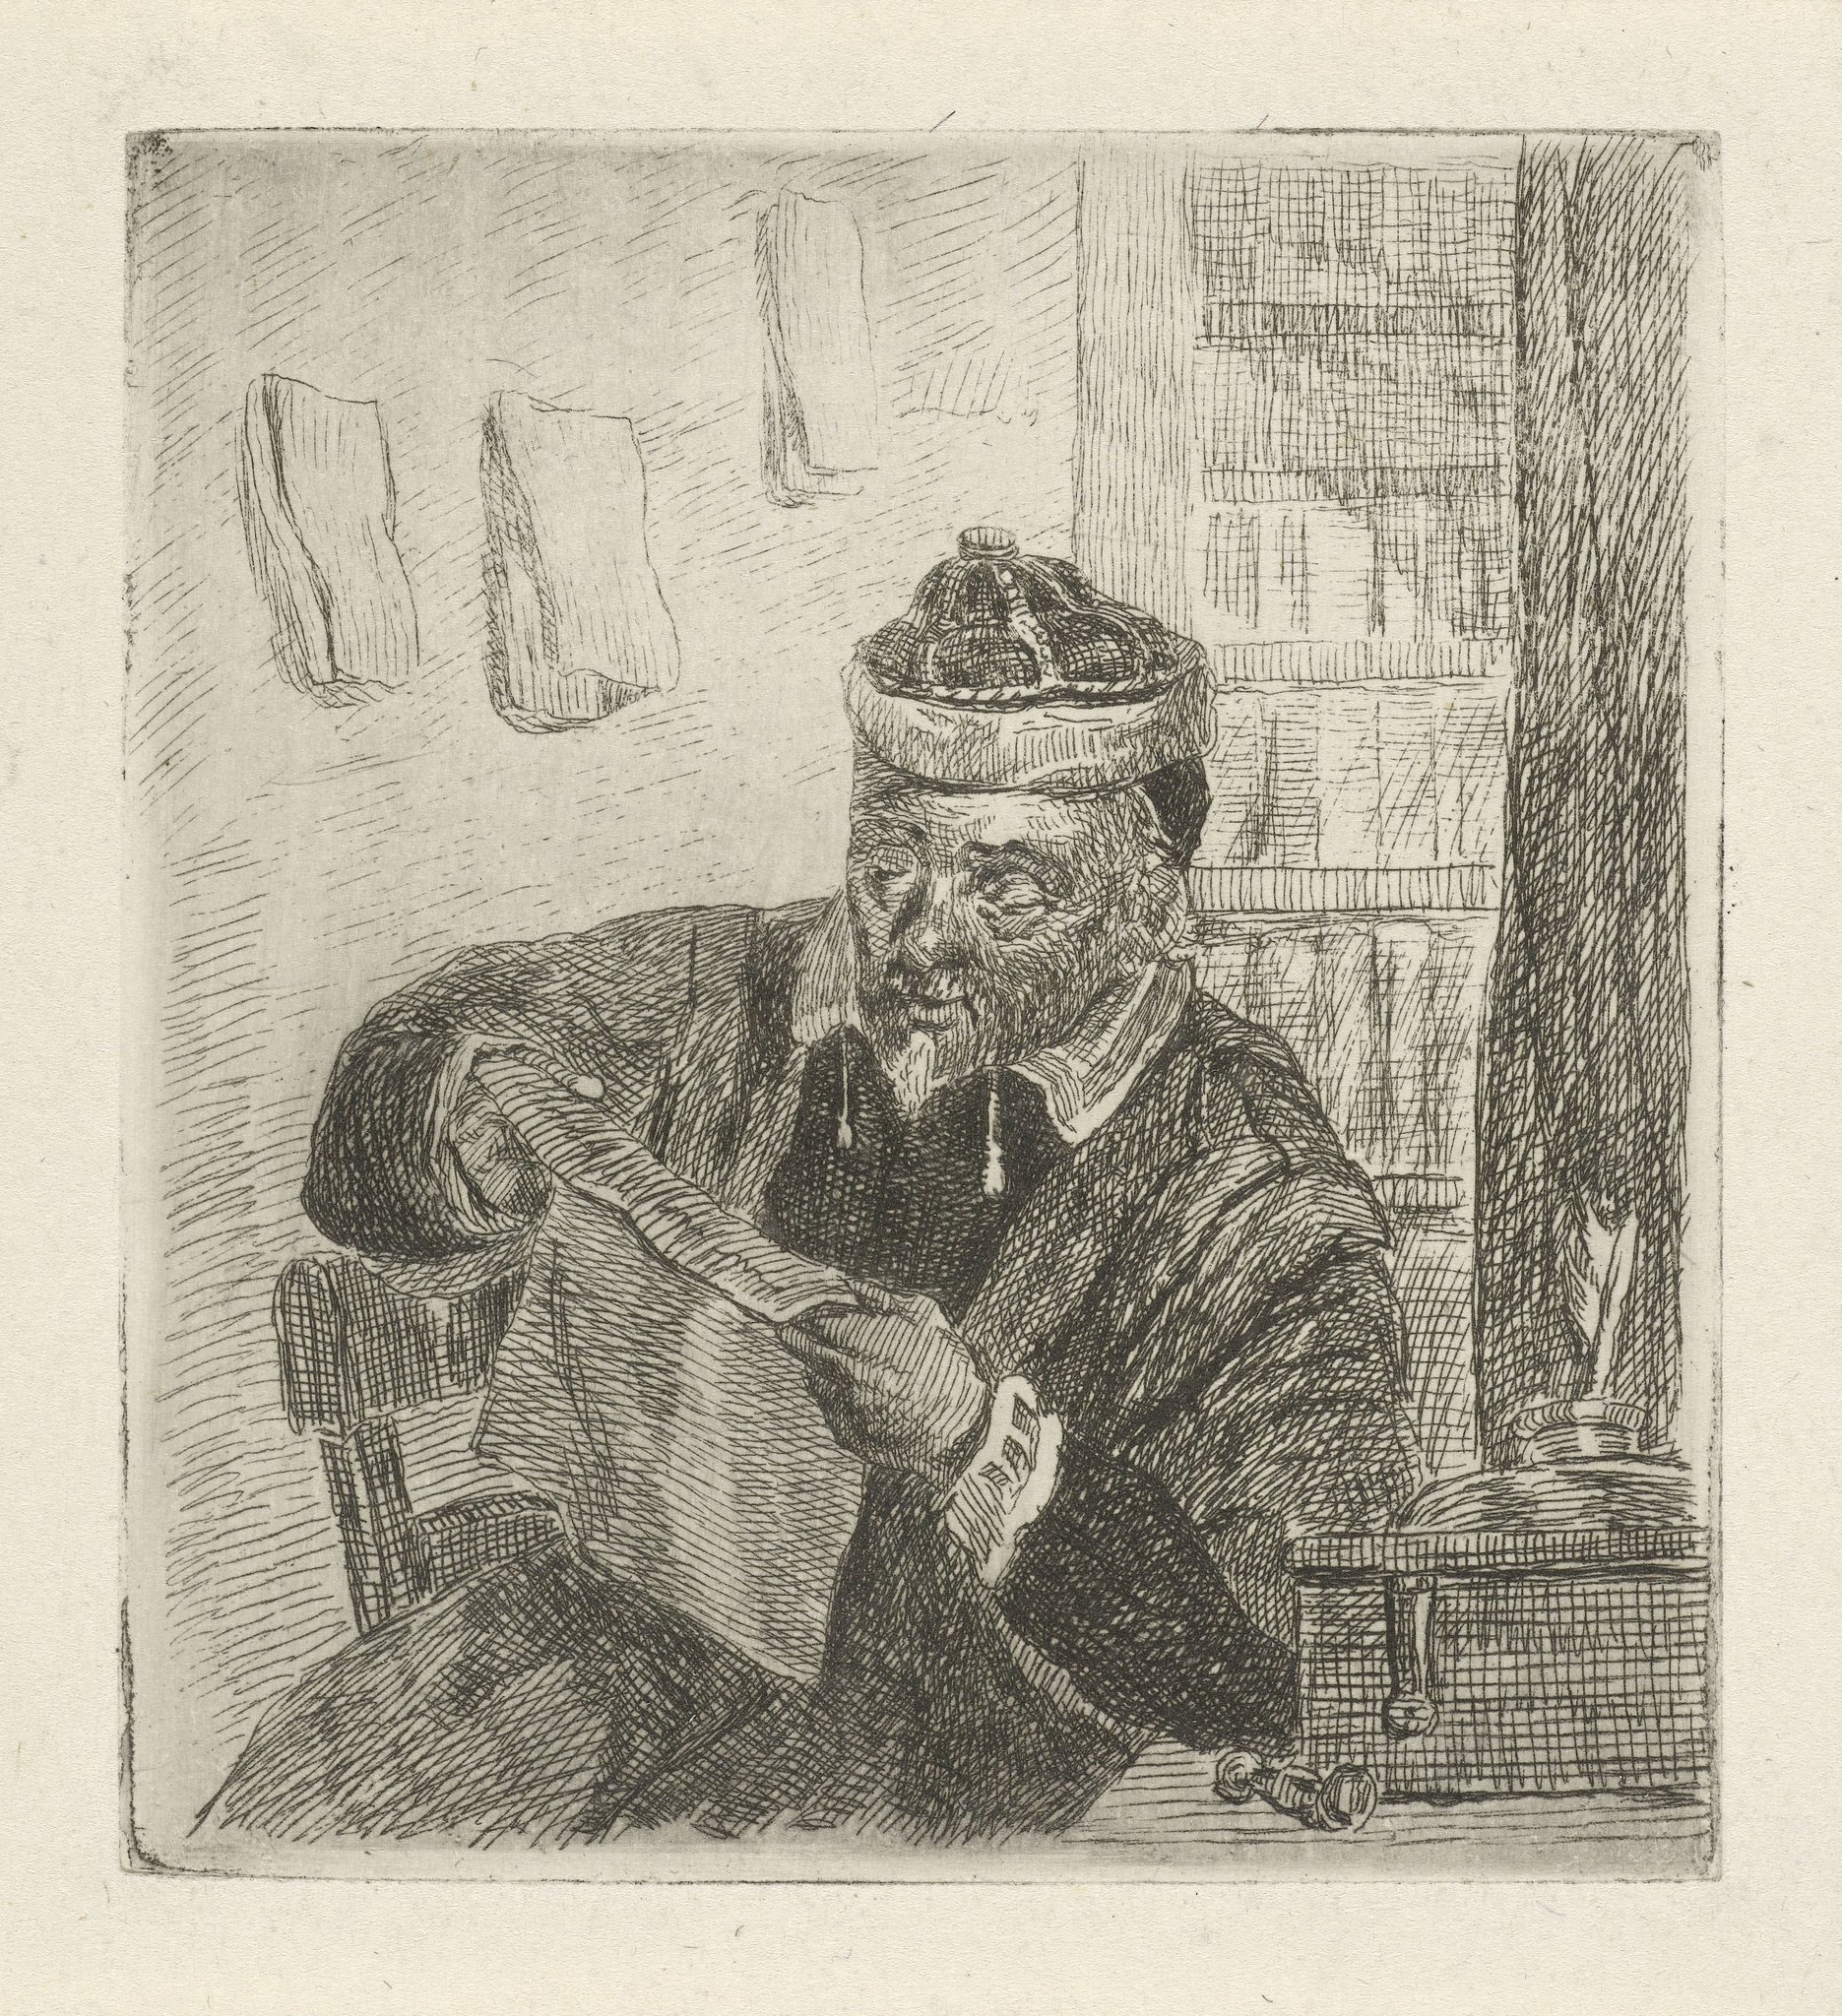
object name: print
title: Lezende man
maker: david van der kellen (1804-1879)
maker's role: die cutter, draughtsman, print maker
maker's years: 1804-1879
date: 1814-1879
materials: paper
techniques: etching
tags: reading, head-gear, adult man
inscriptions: collector's mark: Lugt 2228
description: In een studeerkamer zit een man met een muts op zijn hoofd bij een lessenaar een vel papier te lezen. Op de lessenaar staat een pot met daarin een schrijfveer. Achter de man is een deel van een boekenkast zichtbaar en aan de muur hangen enkele vellen papier.